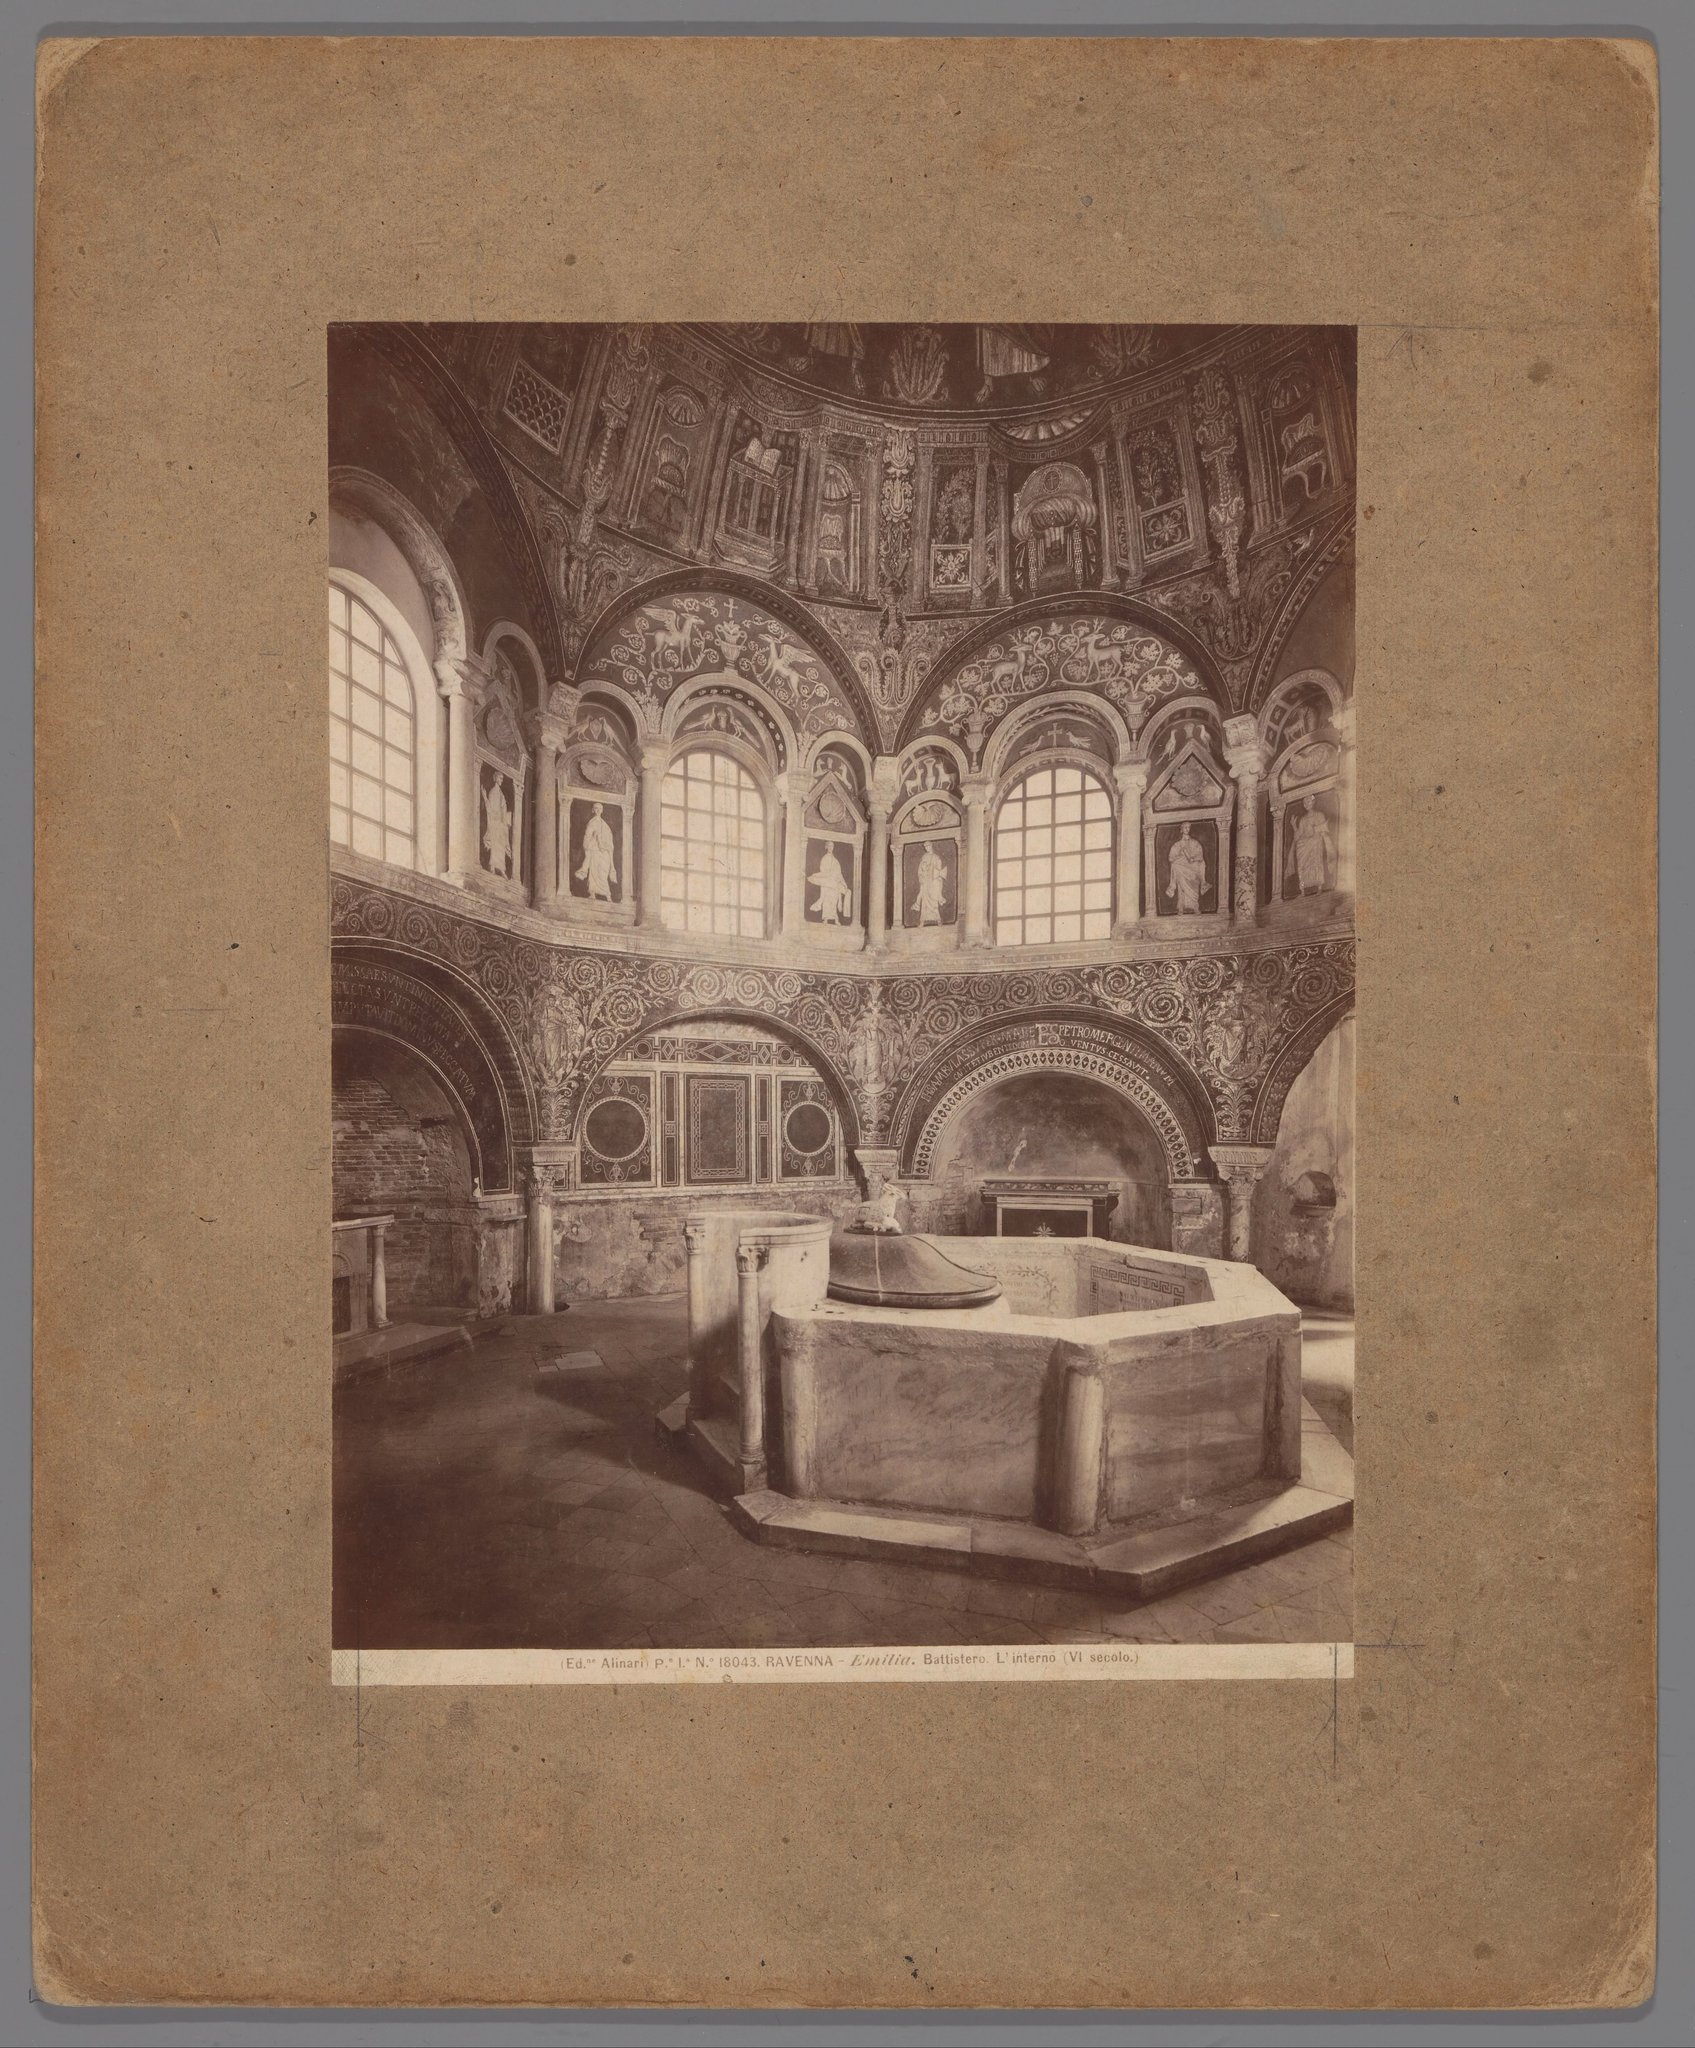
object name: photograph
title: Interieur van het Baptisterium van de arianen te Ravenna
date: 1875-1900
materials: cardboard, photographic support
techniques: albumen print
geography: baptisterium van de arianen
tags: baptismal font, interior ~ representation of a building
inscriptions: number: ‘P.e I.a N.o 19043.’, annotation:, collector's mark: Lugt 3937